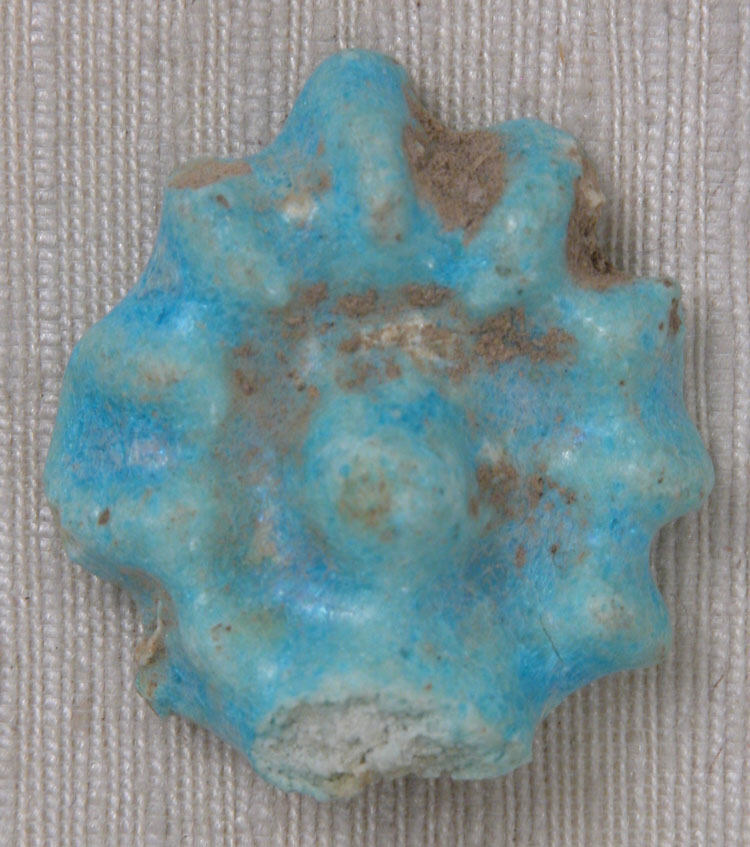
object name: bead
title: Beads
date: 701-1300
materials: earthenware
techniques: glazing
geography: iran